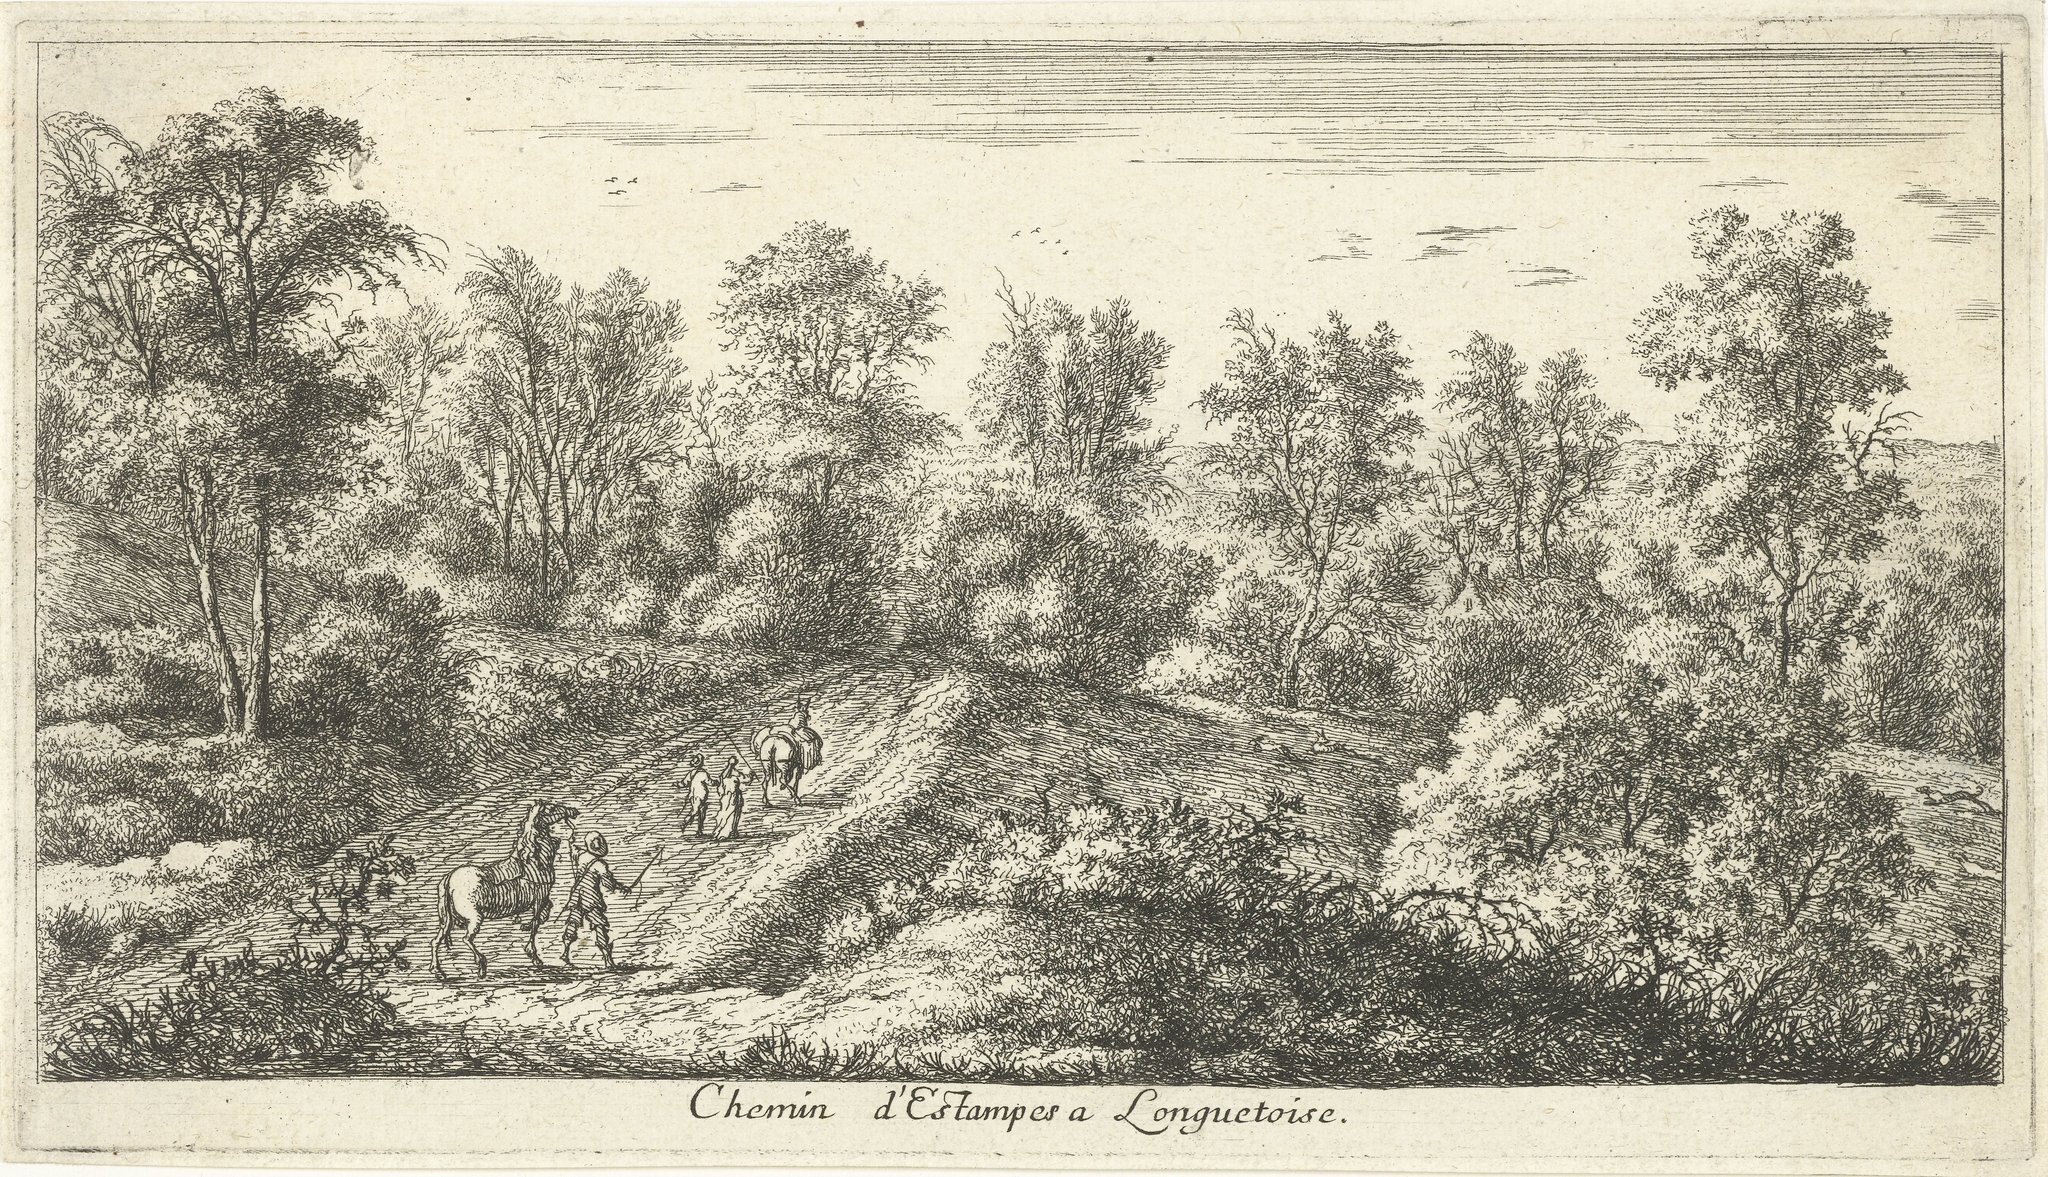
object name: print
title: Pad door bosachtig landschap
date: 1648-1672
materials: paper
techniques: etching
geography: paris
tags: forest path or lane (+ landscape with figures, staffage)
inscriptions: collector's mark: Lugt 2161, collector's mark: Lugt 2228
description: Gezicht op een bosachtig landschap met een pad waarop drie personen, een paard en een ezel lopen.